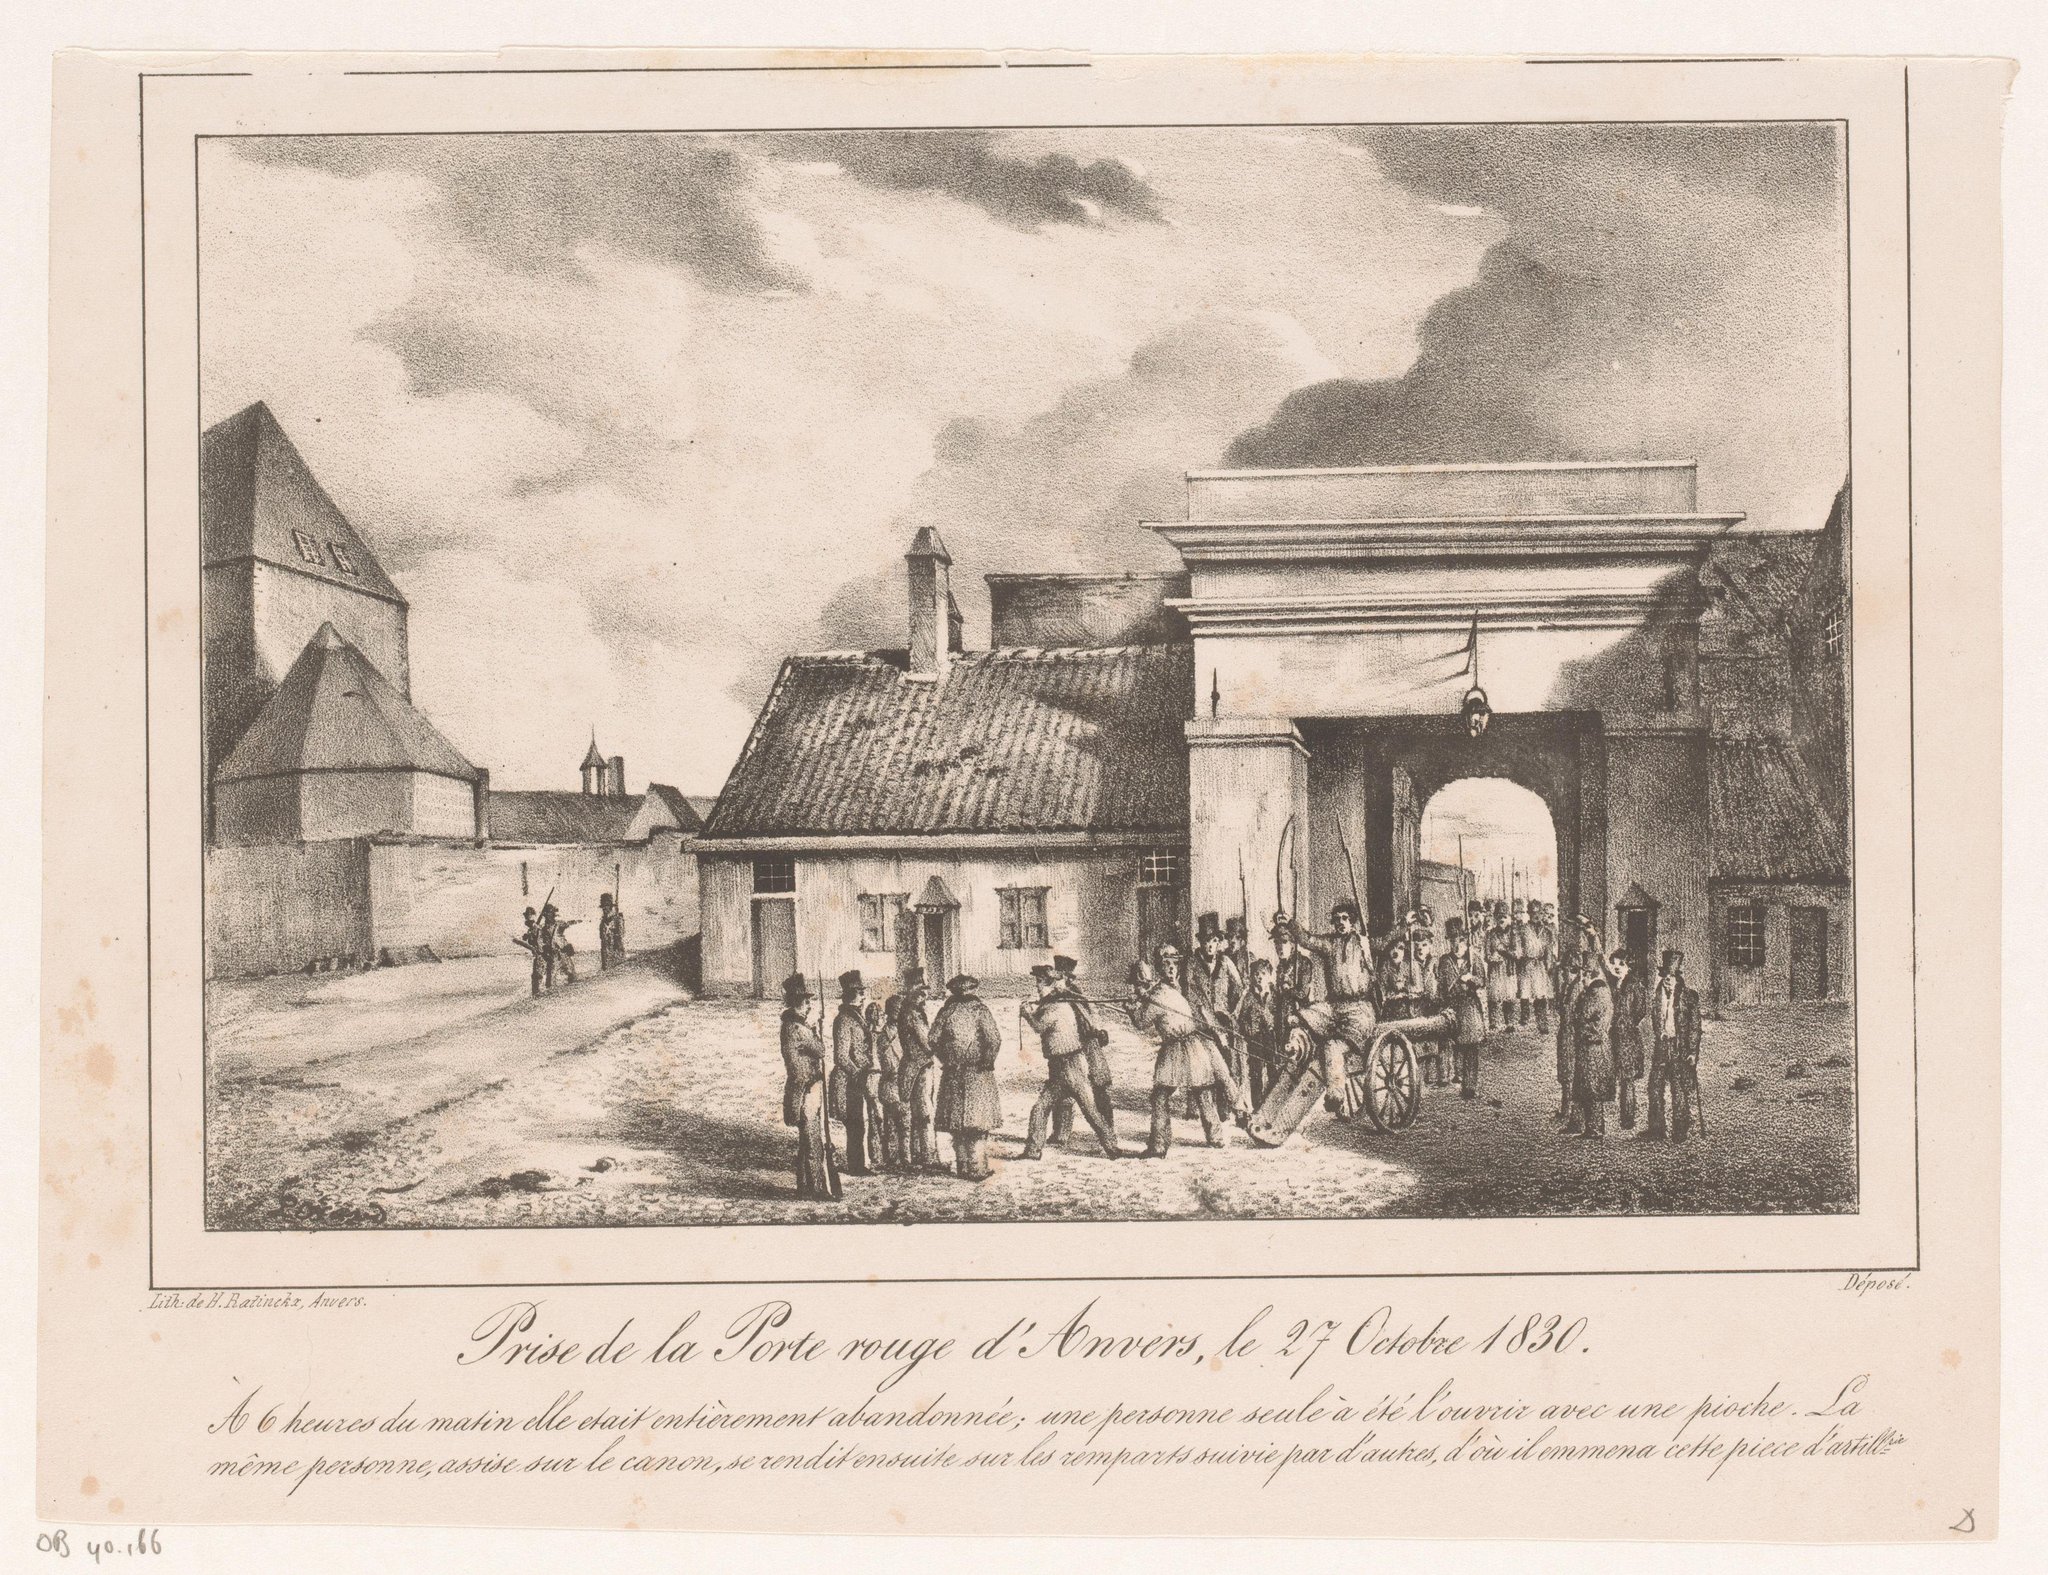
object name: print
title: Prise de la Porte rouge d'Anvers, le 27 Octobre 1830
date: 1830-1831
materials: paper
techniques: lithograph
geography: antwerp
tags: street-fights, riots, antwerp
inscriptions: collector's mark: Lugt 2228, : ‘Déposé’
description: Onder FMH 6516 beschrijft Muller een serie van acht platen over de gebeurtenissen te Antwerpen van 26-27 oktober 1830, gedrukt bij Ratinckx te Antwerpen. In het Supplement worden onder het nummer 6516A nog eens negen platen vermeld die waarschijnlijk tot dezelfde serie behoren. Daarnaast bezit het RPK nog twee platen die waarschijnlijk tot dezelfde reeks behoren. Hier worden deze negentien platen beschreven als deel uit makend van één en dezelfde serie.